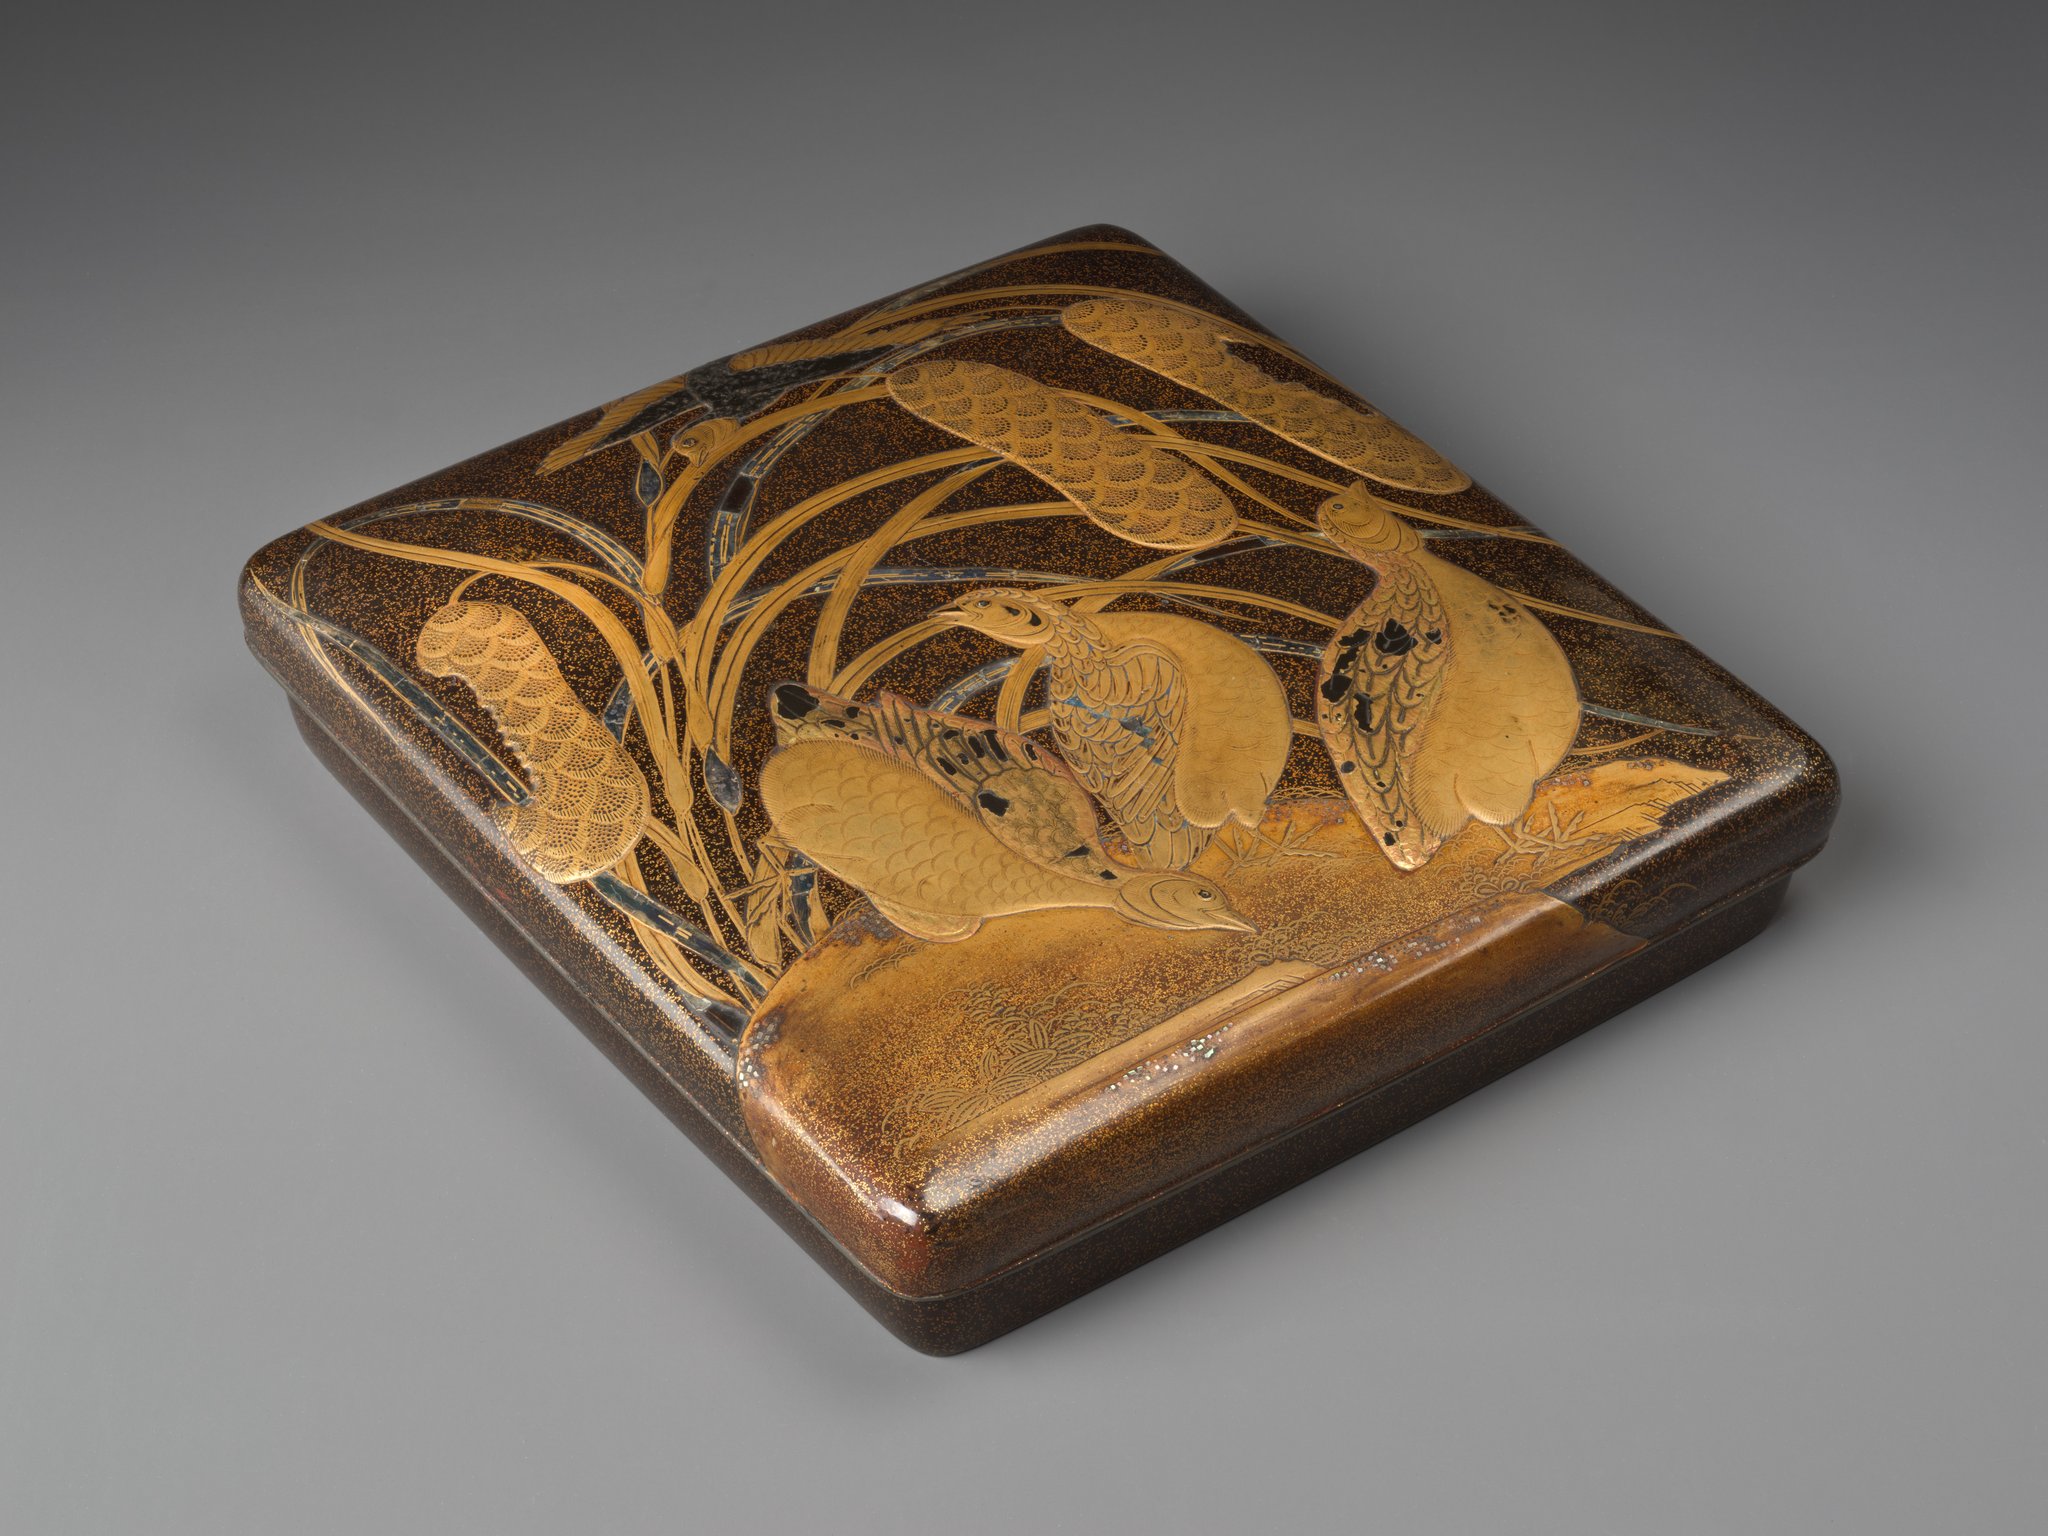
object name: box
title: Writing box with decoration of quails and millet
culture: japanese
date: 1601-1700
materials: lacquer